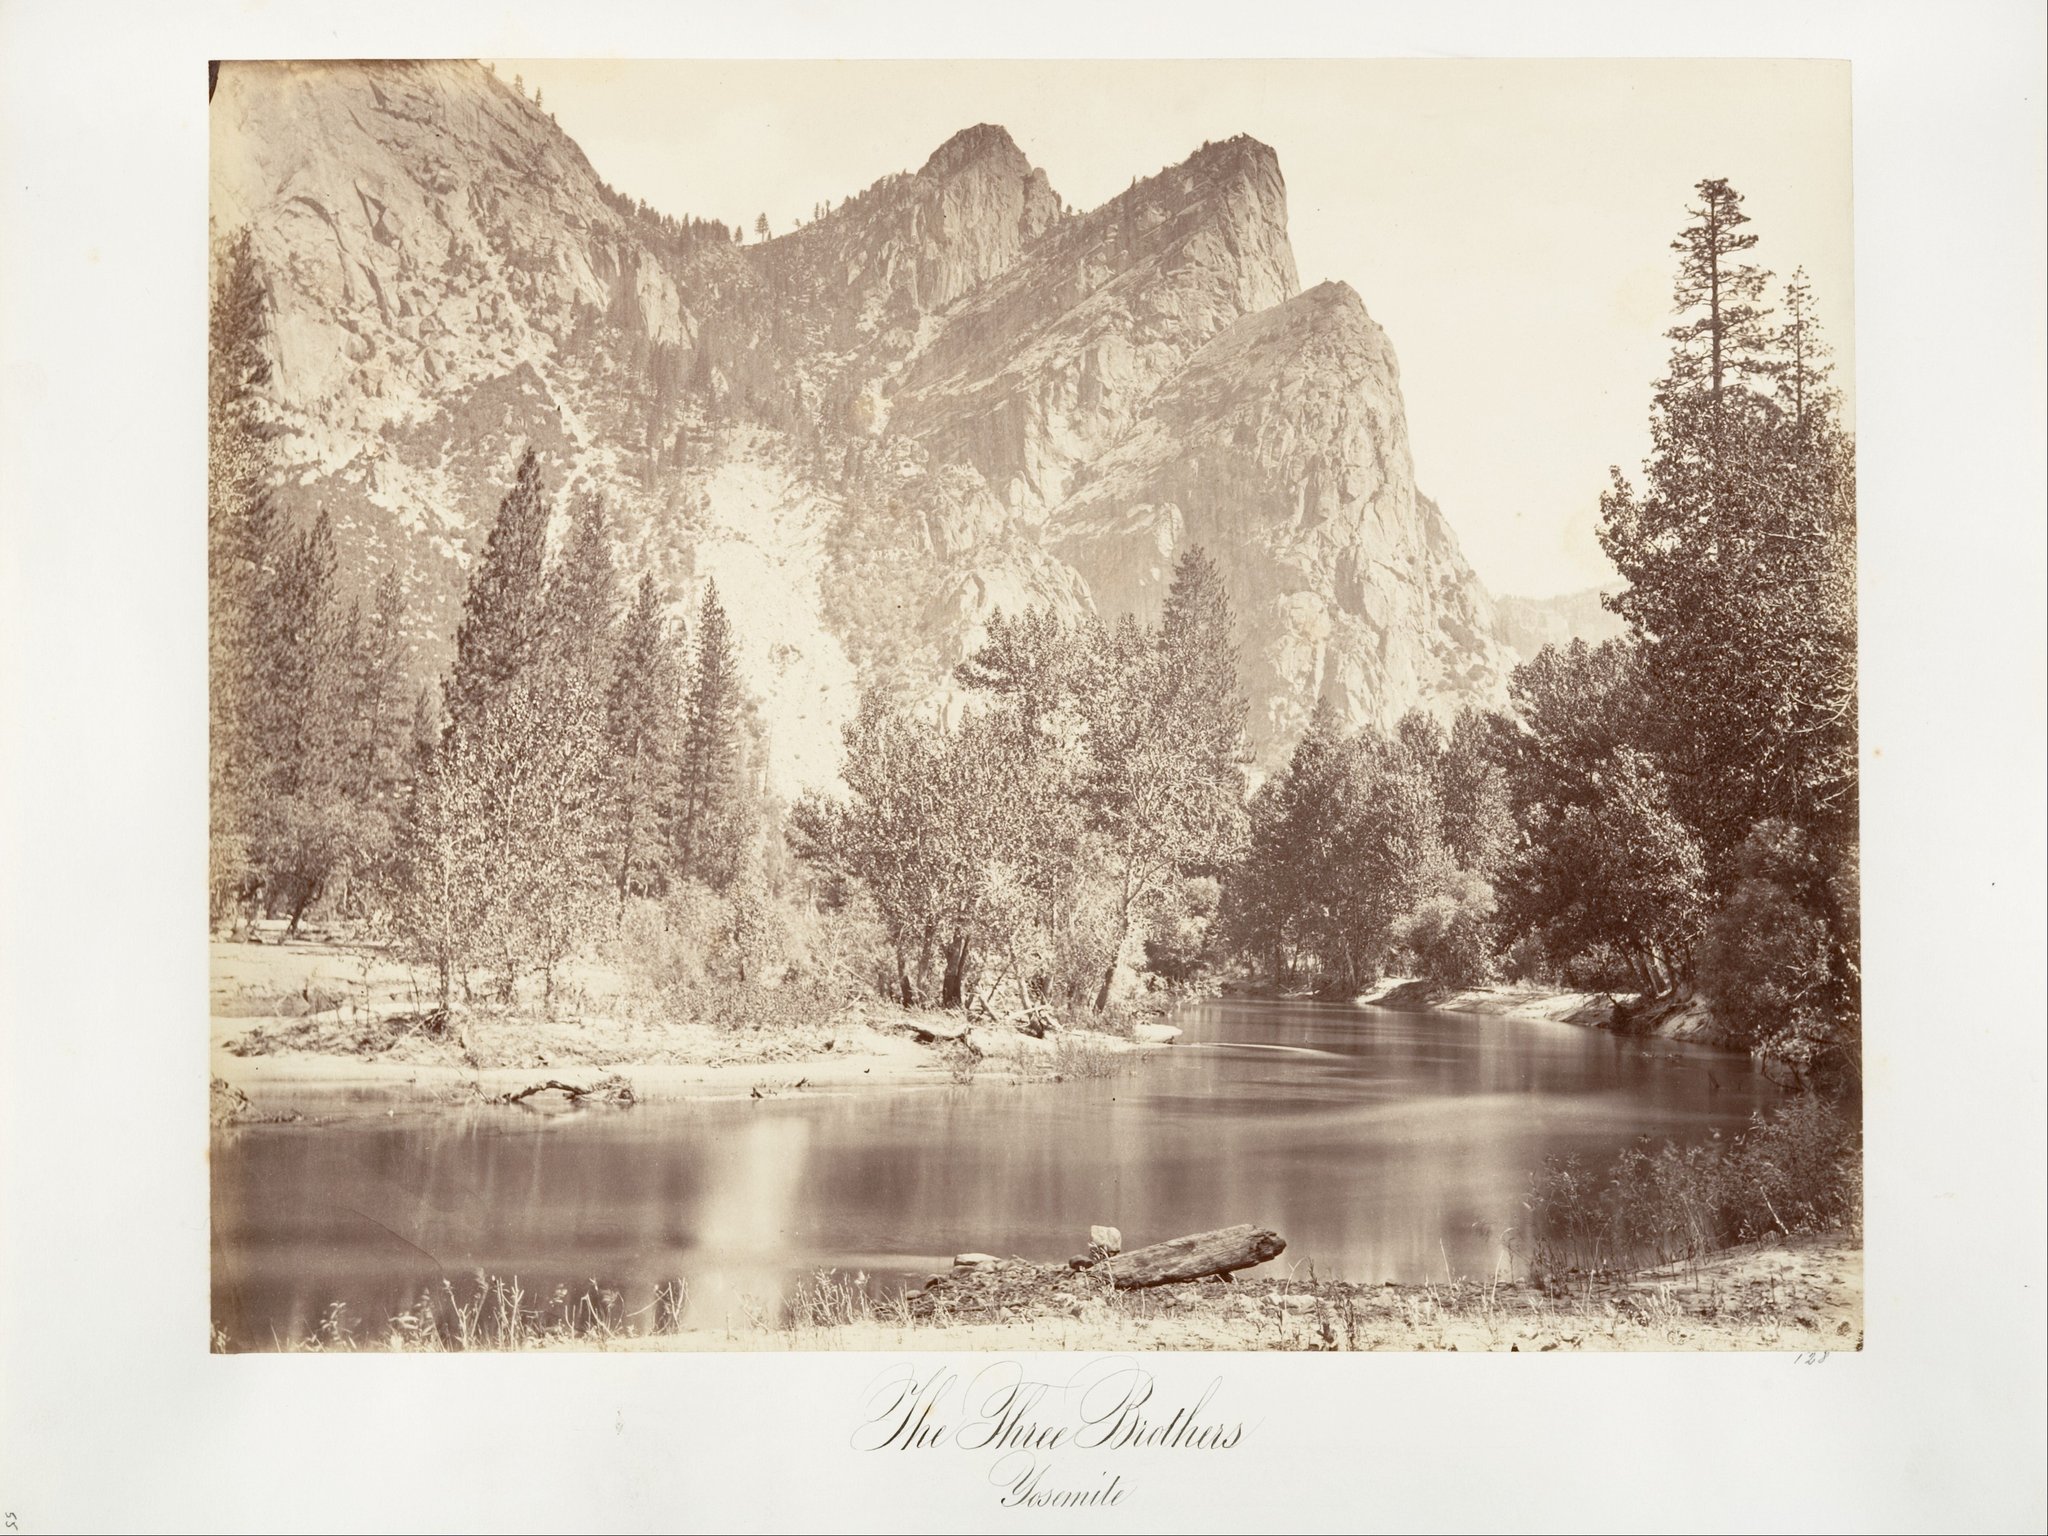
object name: photograph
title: The Three Brothers, Yosemite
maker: carleton e. watkins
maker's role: artist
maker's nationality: american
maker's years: 1829-1916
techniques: albumen silver print, glass negative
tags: rivers,mountains,landscapes